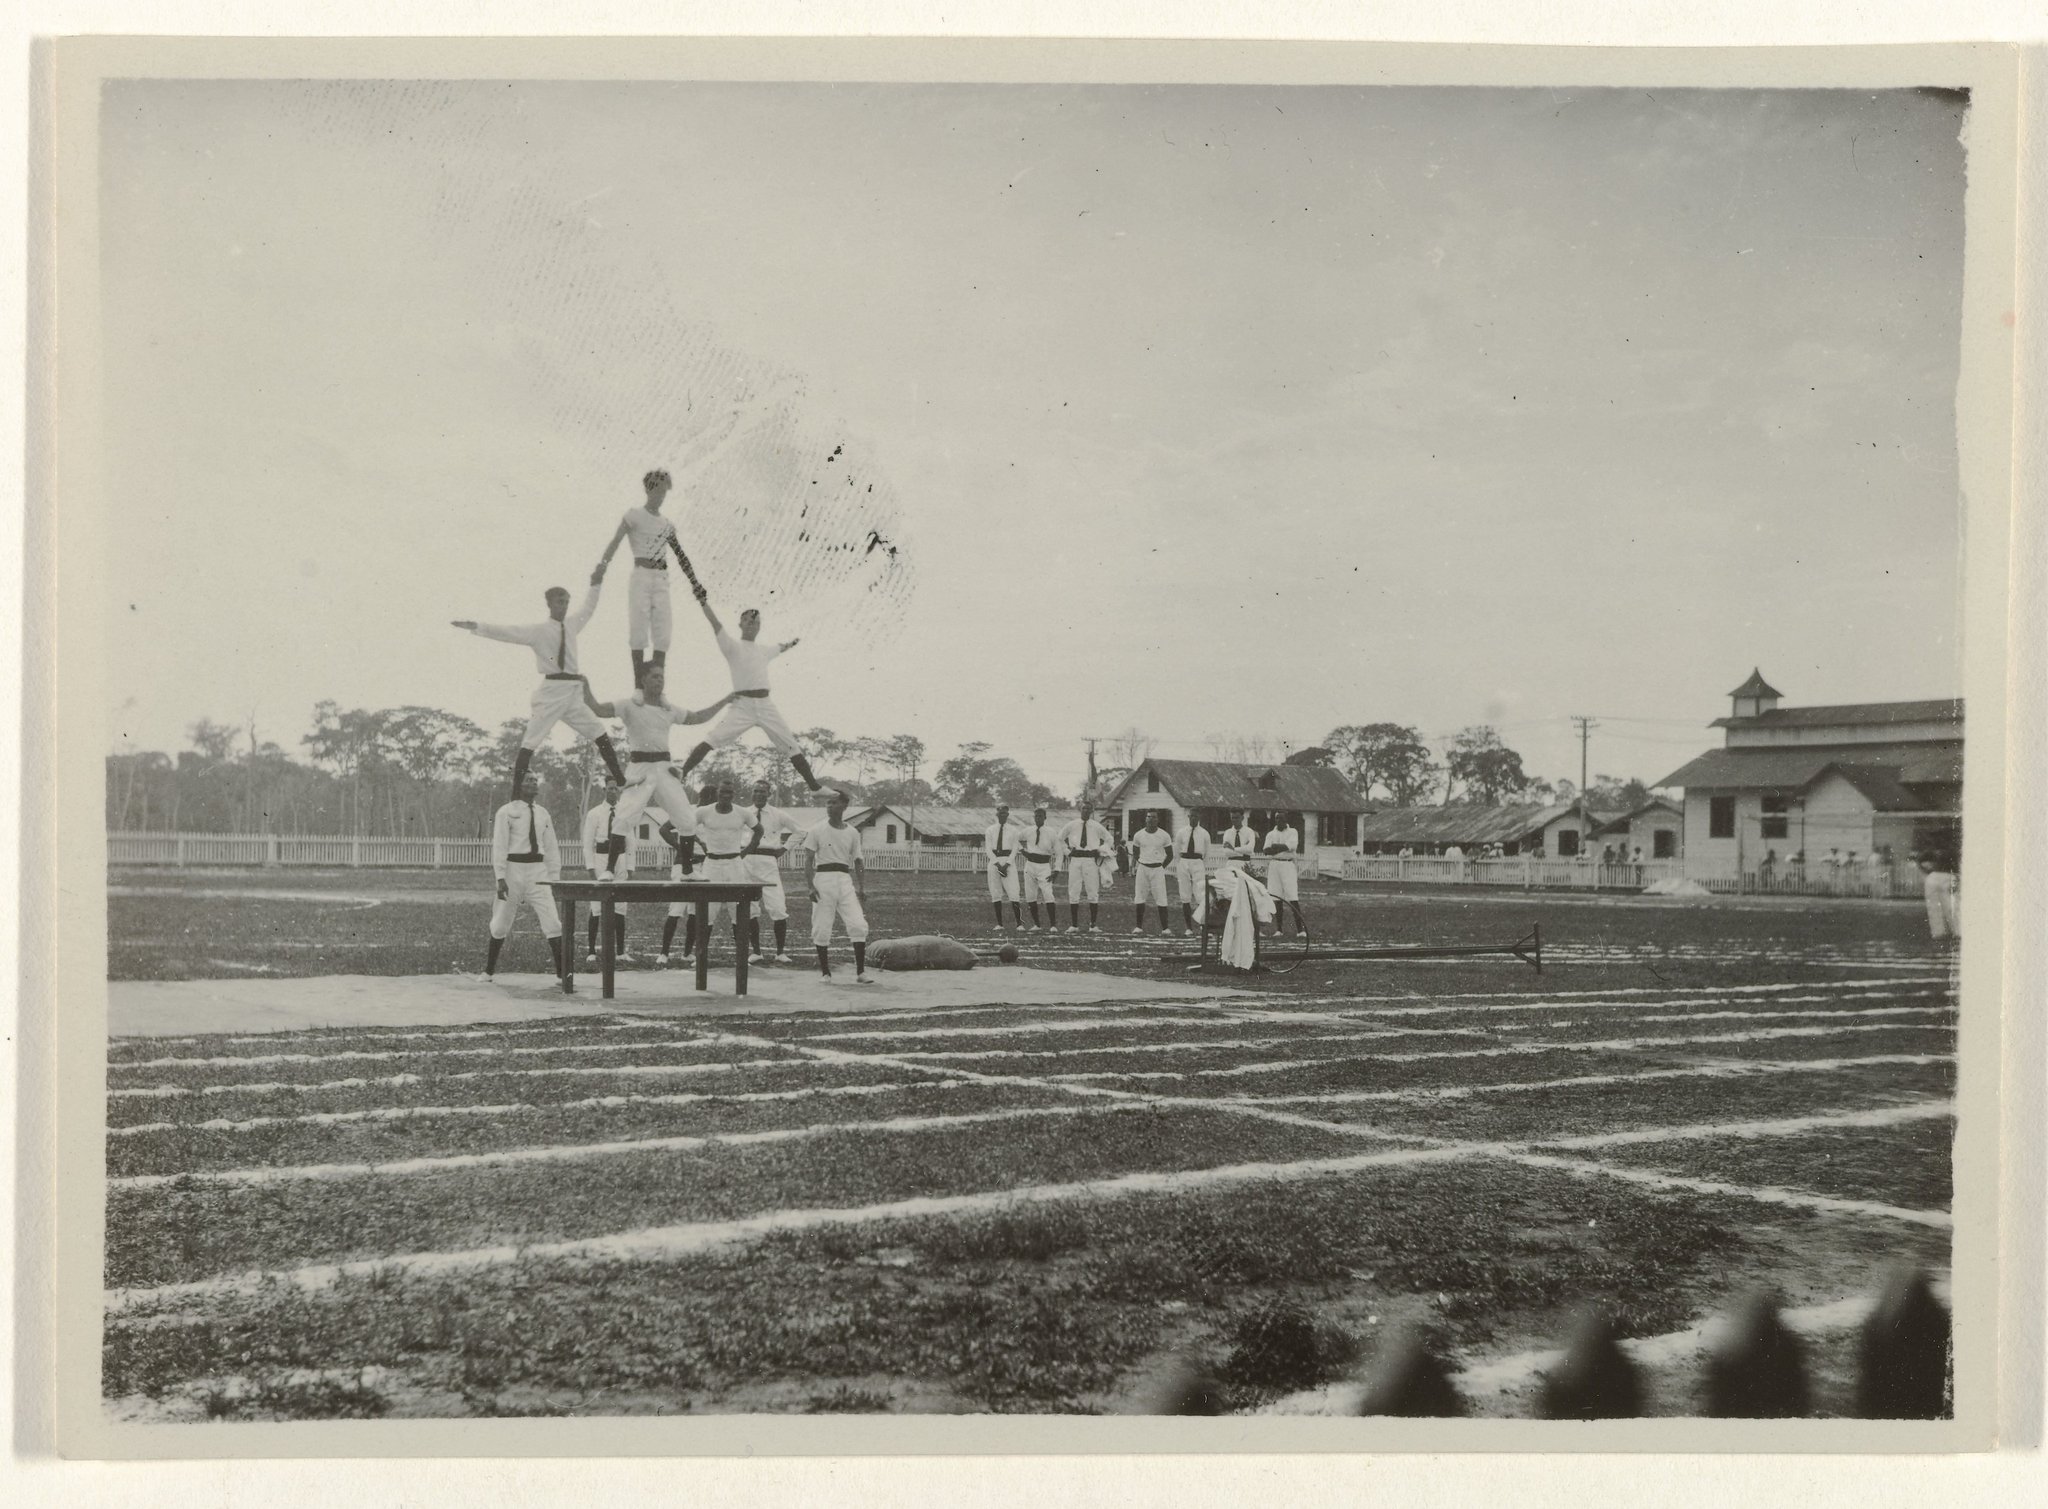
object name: photograph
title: Gymnastiekdemonstratie in Moengo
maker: Anonymous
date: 1929-1930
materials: photographic support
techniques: photography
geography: suriname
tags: athletics, gymnastics